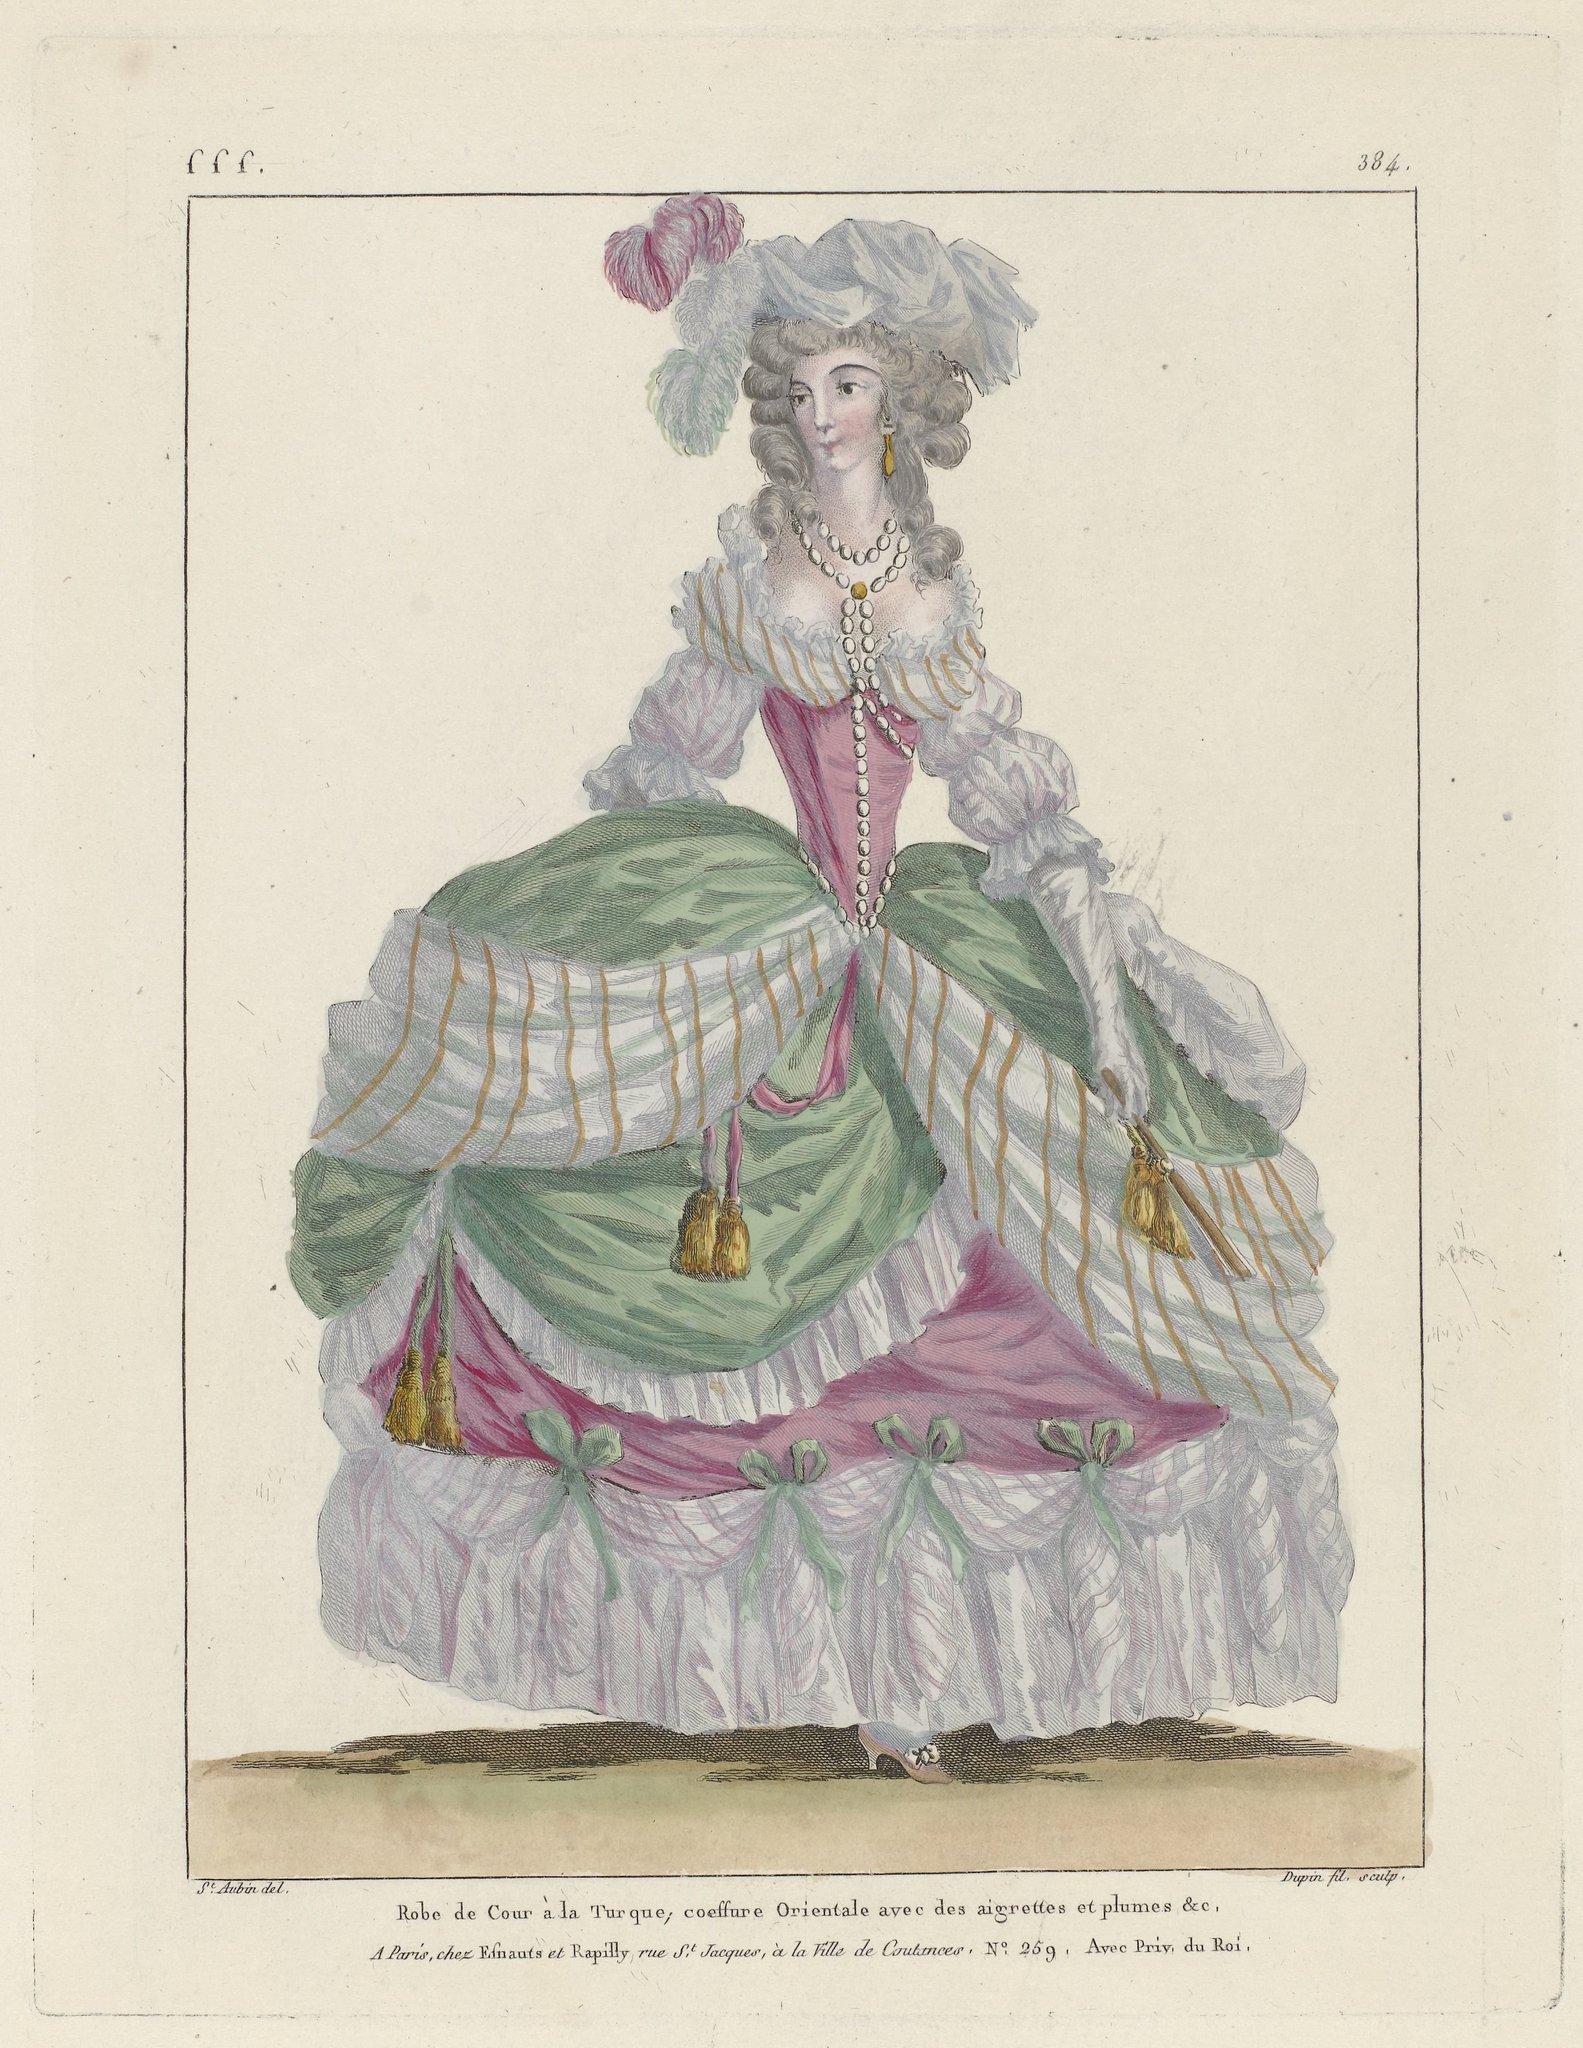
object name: fashion print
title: Gallerie des Modes et Costumes Français, 1787, sss 384 : Robe de Cour à la Turque; (...)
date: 1787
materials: paper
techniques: engraving, hand coloring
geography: paris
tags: bow (ornamental part of clothing) (+ women's clothes), ear-rings (+ women's clothes), dress, gown: court gown or court dress (+ women's clothes), dress, gown (robe à la turque) (+ women's clothes), styles of hairdress - aa - ~ women, fashion plates, head-gear: hat (+ women's clothes), shoes, sandals (+ women's clothes), gloves, mittens, etc. (+ women's clothes), fan (+ women's clothes), necklace (+ women's clothes)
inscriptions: address: ‘A Paris chez Esnauts et Rapilly rue St. Jacques, à la Ville de Coutances, No. 259. Avec Priv. du Roi.’, caption: ‘Robe de Cour à la Turque; coeffure Orientale avec des aigrettes et plumes & c.’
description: Vrouw in een hofjapon 'à la Turque'. De japon is versierd met linten en kwasten, draperingen van gestreepte stof, strikken en afgezet met gerimpelde stroken stof. 'Coeffure Orientale' versierd met aigrettes en veren. Verdere accessoires: oorbel in het linkeroor, collier bestaande uit twee snoeren, lange handschoen, waaier, schoen met hak en strik. Uit serie sss. 3e Cahier de Grandes Robes d'étiquette de la Cour de France faisaint suite aux costumes français, Gallerie des Modes et Costumes Français.